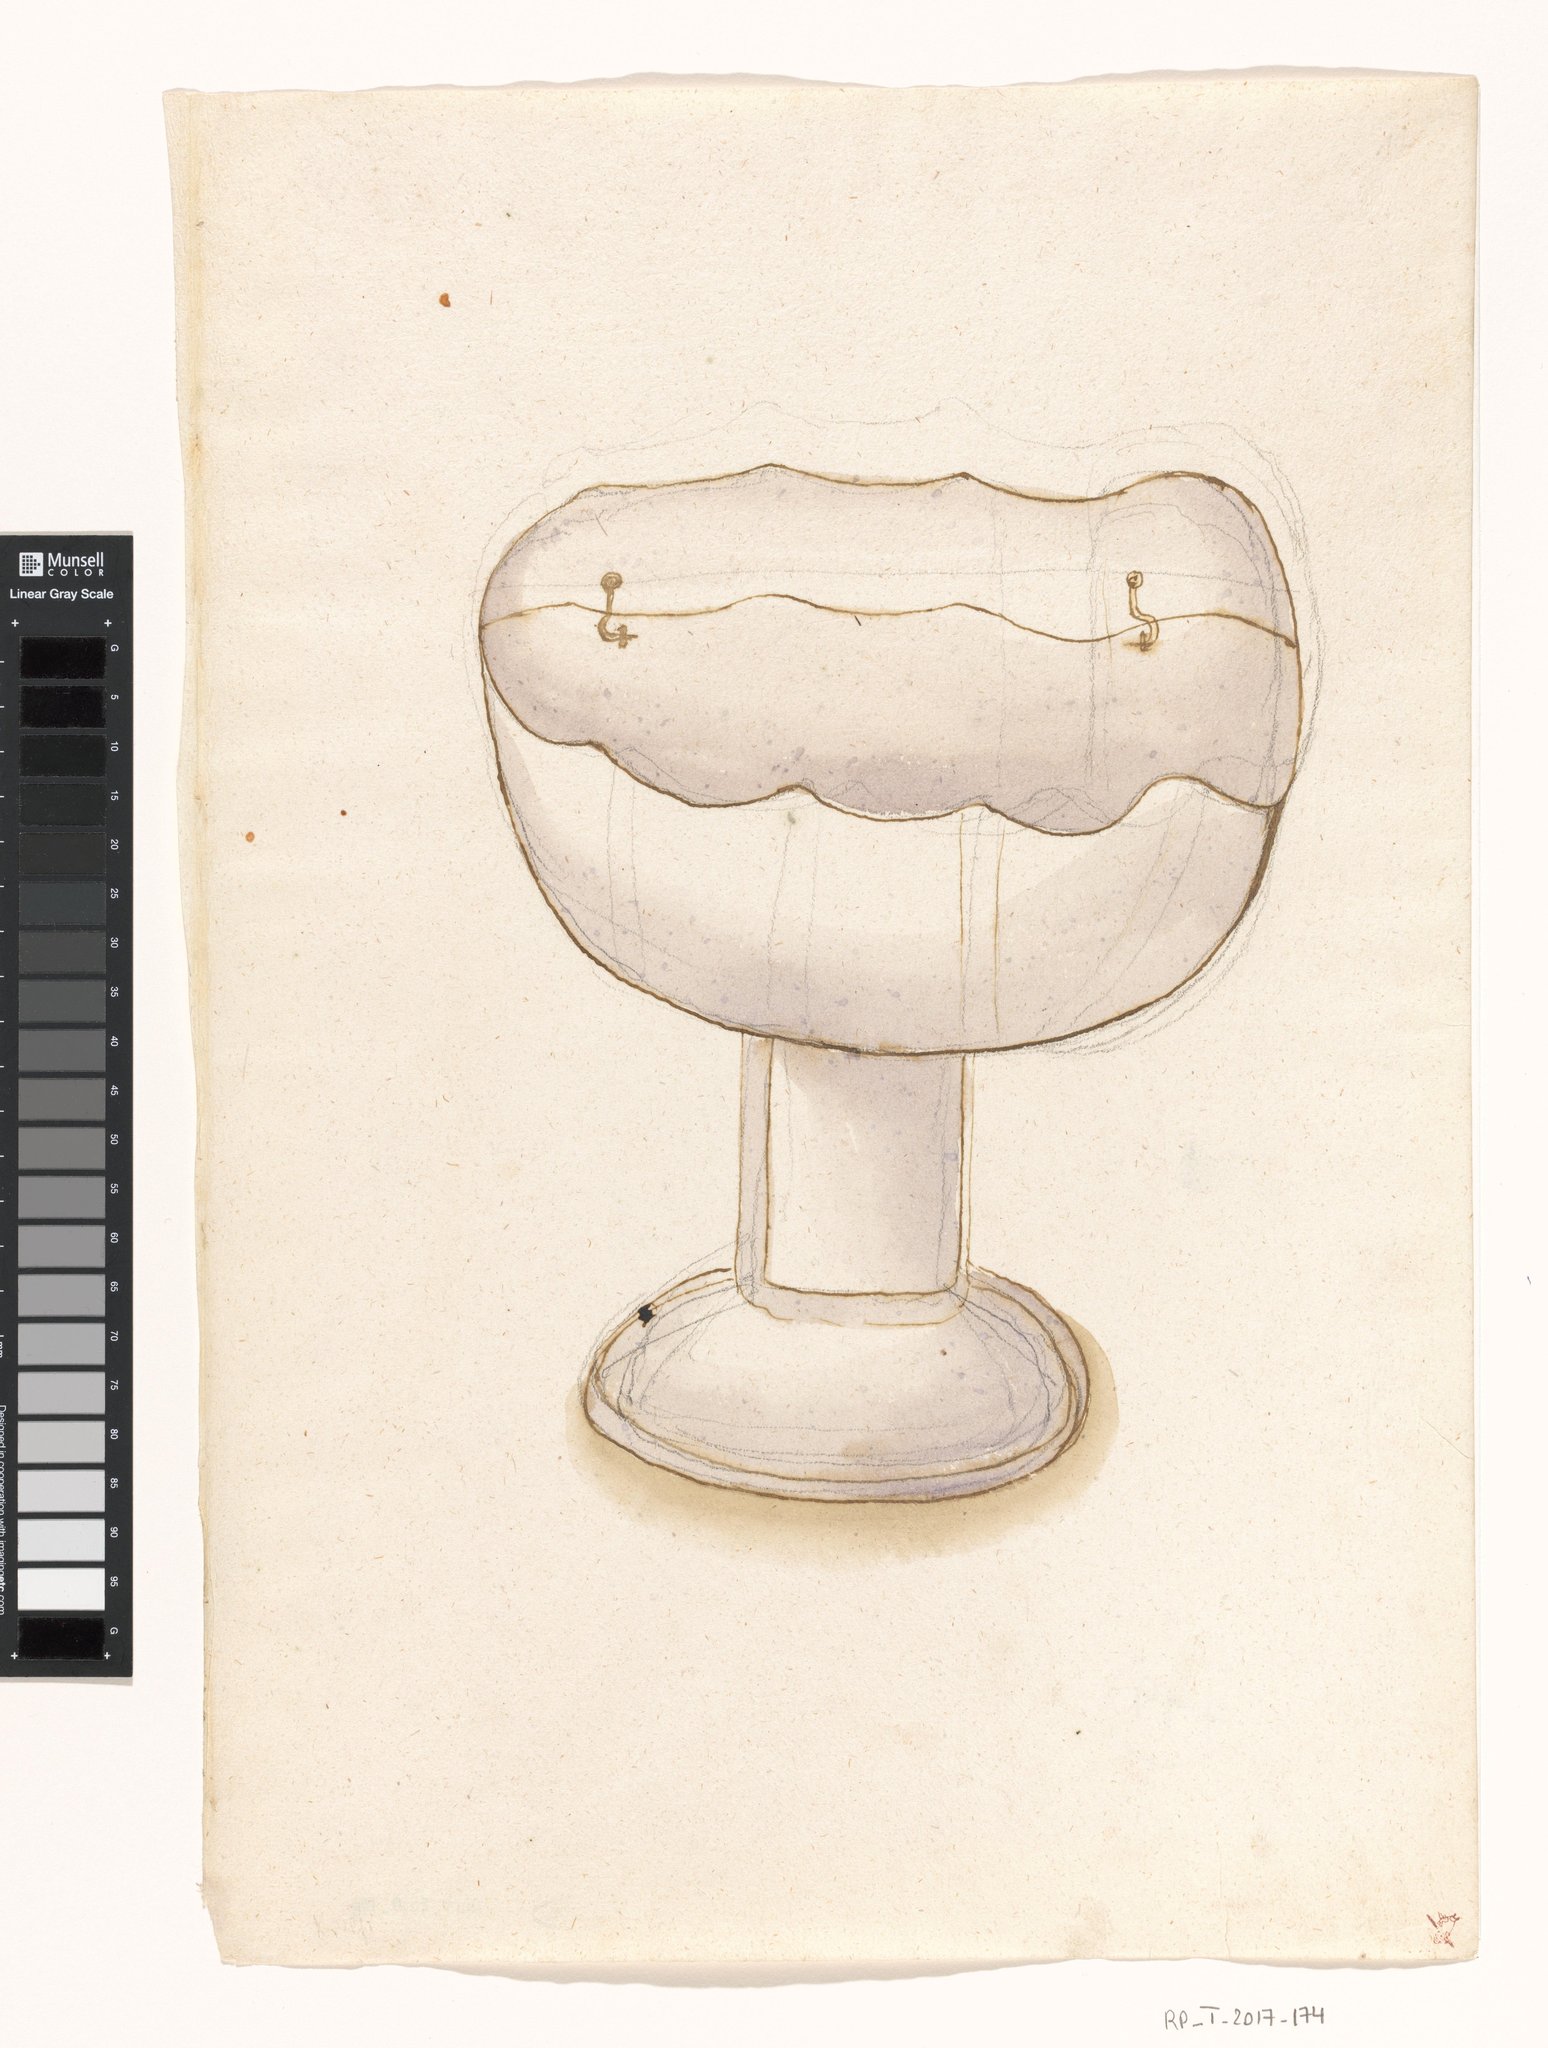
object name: drawing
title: Tekening van een foedraal behorende bij de rode kelk van halfedelsteen met goudbeslag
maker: Anonymous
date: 1550-1600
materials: ink, watercolor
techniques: drawing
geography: germany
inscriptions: watermark: ‘gekroonde slang (verticaal, op boven, staart naar beneden)’, collector's mark: Lugt 3893